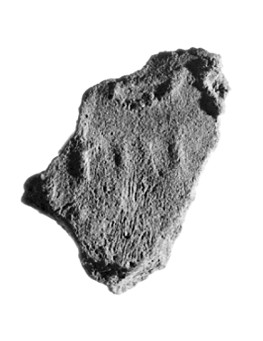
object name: sealing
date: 2030-1640 BCE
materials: clay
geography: egypt